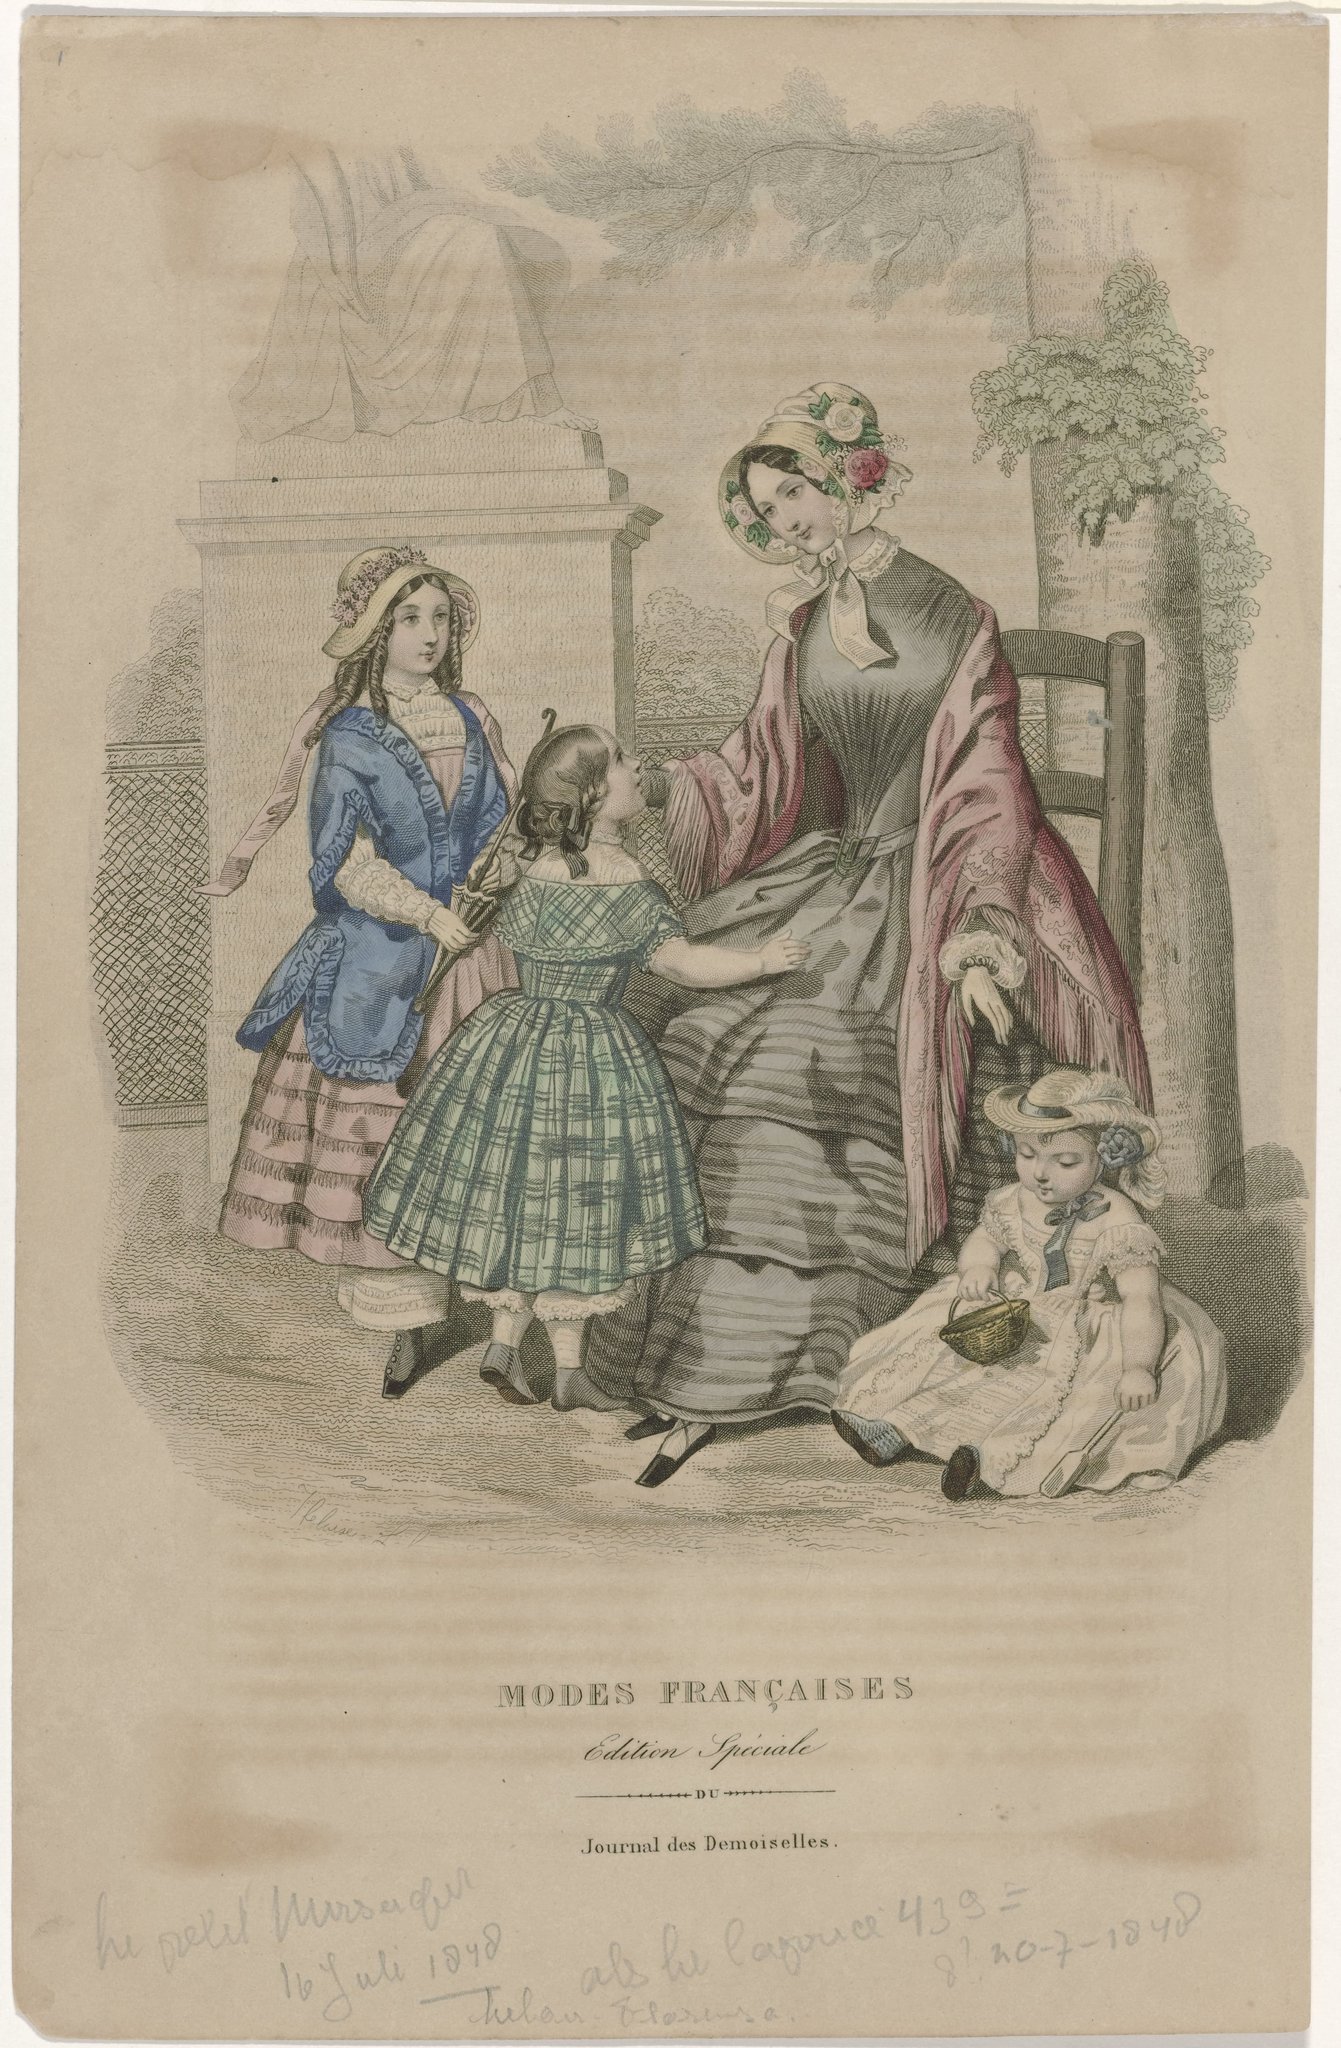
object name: fashion print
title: Journal des Demoiselles, juli 1848 : Modes Françaises (...)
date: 1848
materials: paper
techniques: engraving, hand coloring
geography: paris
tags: clothing for the upper part of the body (shawl) (+ women's clothes), head-gear: hat (+ girls' clothes), shoes, sandals (+ girls' clothes), underclothes for the lower part of the body: bloomers, fashion plates, head-gear: hat (+ women's clothes), gloves, mittens, etc. (+ women's clothes), dress, gown (+ women's clothes), neck-gear ~ clothing (+ women's clothes), statues, sculptures in garden, dress, gown (+ girls' clothes)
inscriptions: caption: ‘Modes Françaises, Edition Spéciale du Journal des Demoiselles’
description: Een vrouw en drie meisjes in een park. Prent uit het modetijdschrift Journal des Demoiselles (1833 -1922).